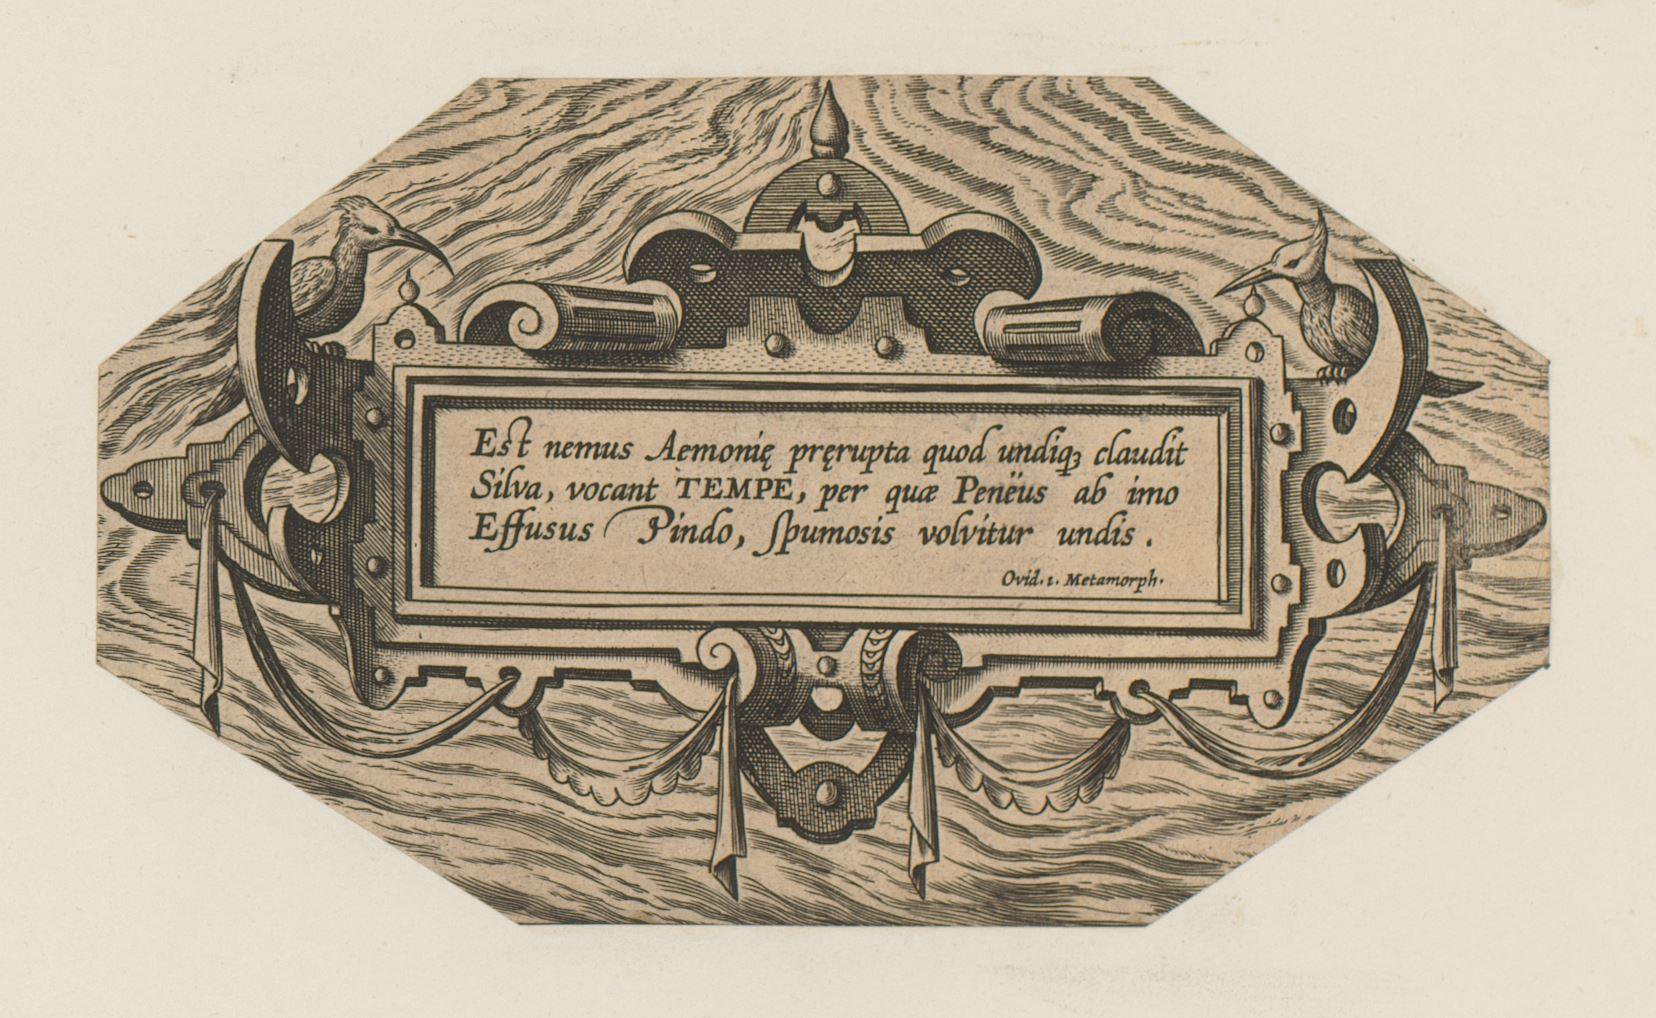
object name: album leaf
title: Cartouche van een afbeelding van het Tempedal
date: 1590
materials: paper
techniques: engraving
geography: antwerp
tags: birds, ornament ~ cartouche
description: Langwerpige rolwerkcartouche met links en rechts een vogel en onderaan slingers. In de cartouche een drieregelig citaat uit Ovidius' Metamorfosen. De cartouche is een fragment van een afbeelding van het Tempedal. De prent maakt deel uit van een album.